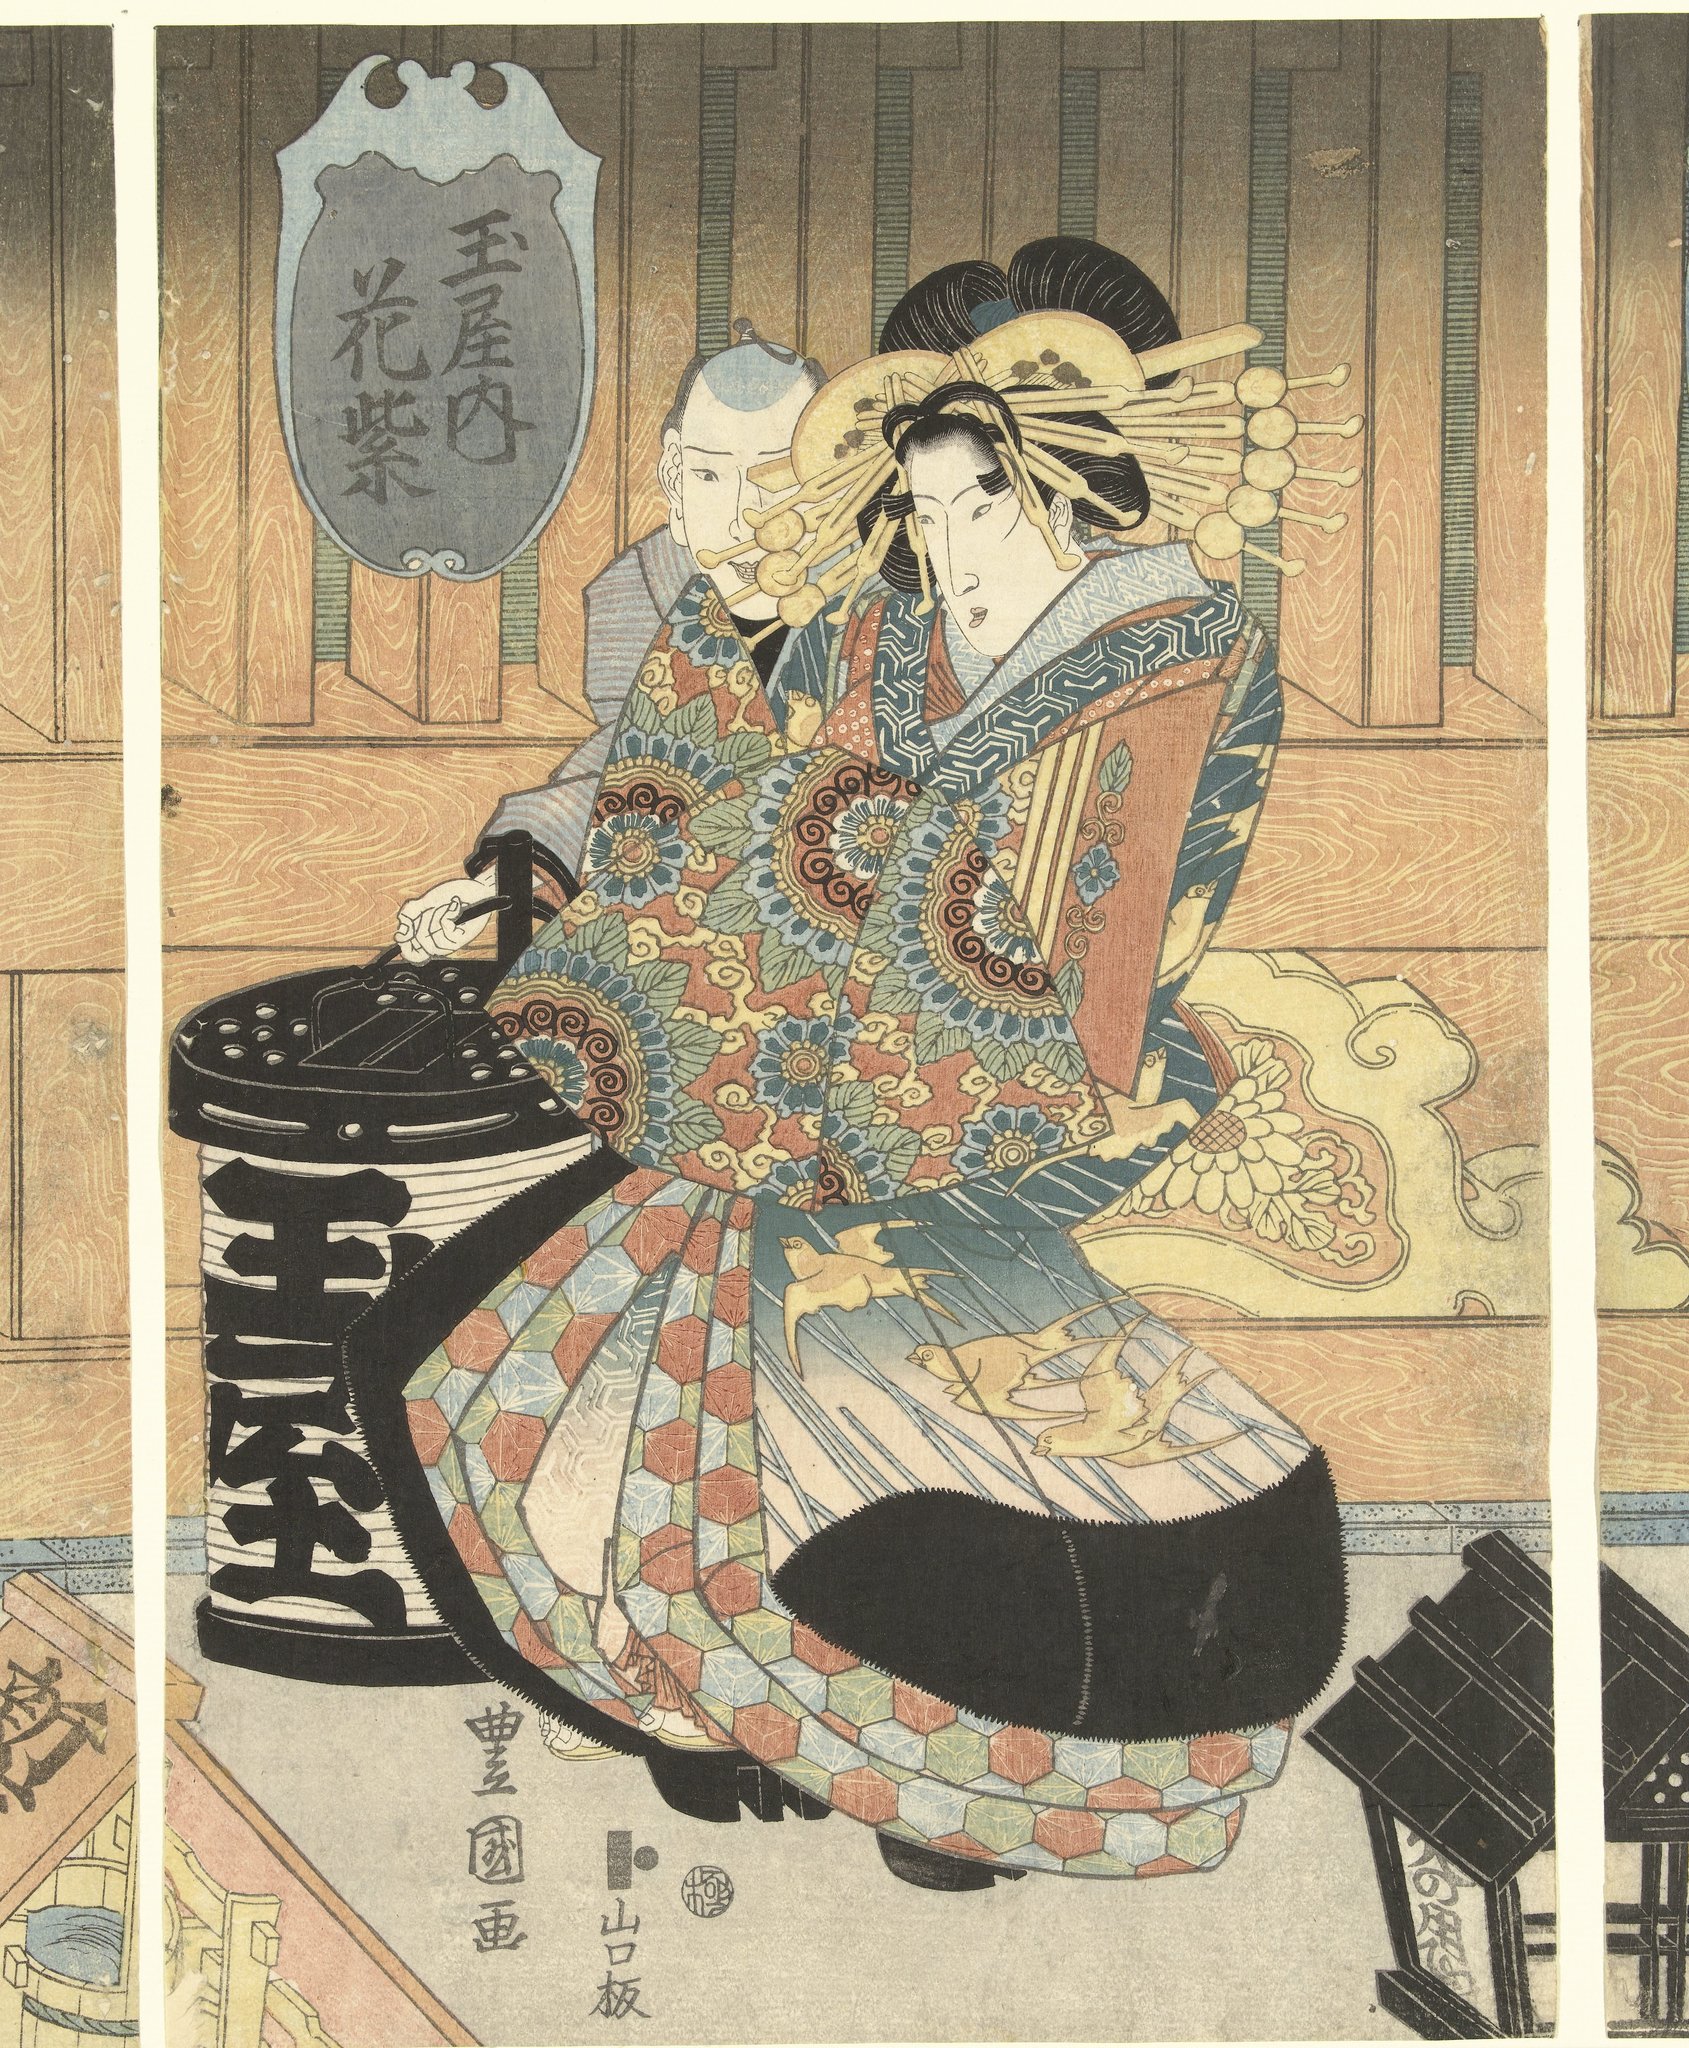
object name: print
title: Drie courtisanes uit het Tamaya huis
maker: utagawa toyokuni (ii)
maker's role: print maker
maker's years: 1777-1835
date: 1828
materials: paper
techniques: woodcut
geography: tokyo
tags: courtesan, hetaera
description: De courtisane Hanamurasaki in kimono met vogel patroon, staand bij man met grote zwart-witte lantaarn in rechter hand; tegen houten wand.